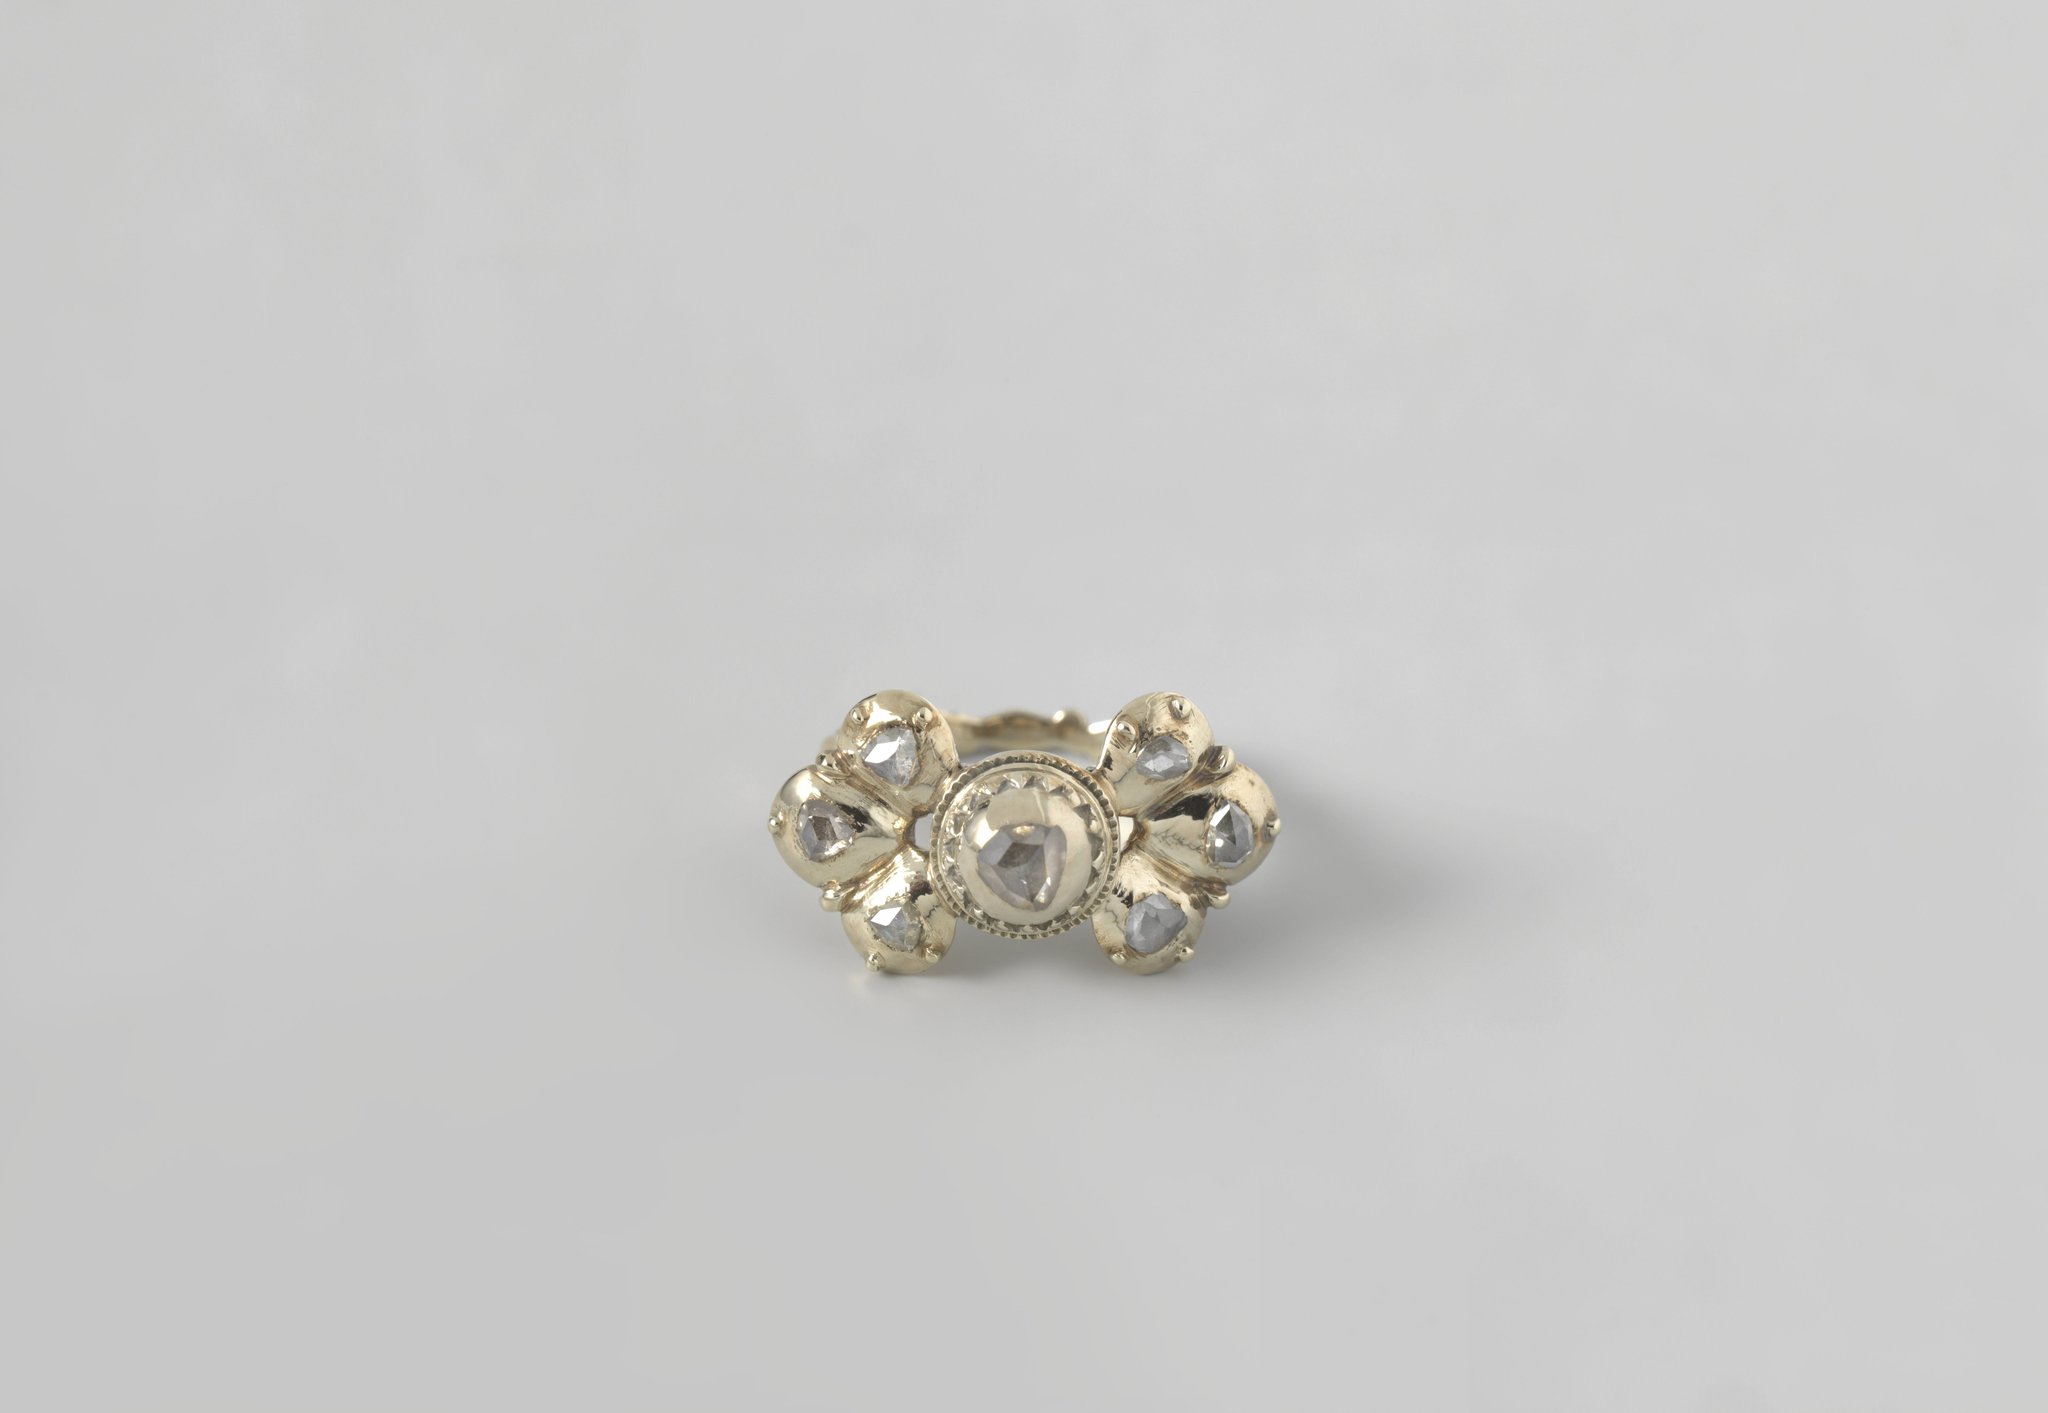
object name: jewellery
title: Entouragering, de hoep in de vorm van een strik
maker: Anonymous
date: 1670-1690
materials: diamond, silver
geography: netherlands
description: Ring van goud. De stenen in de vorm van een strik.